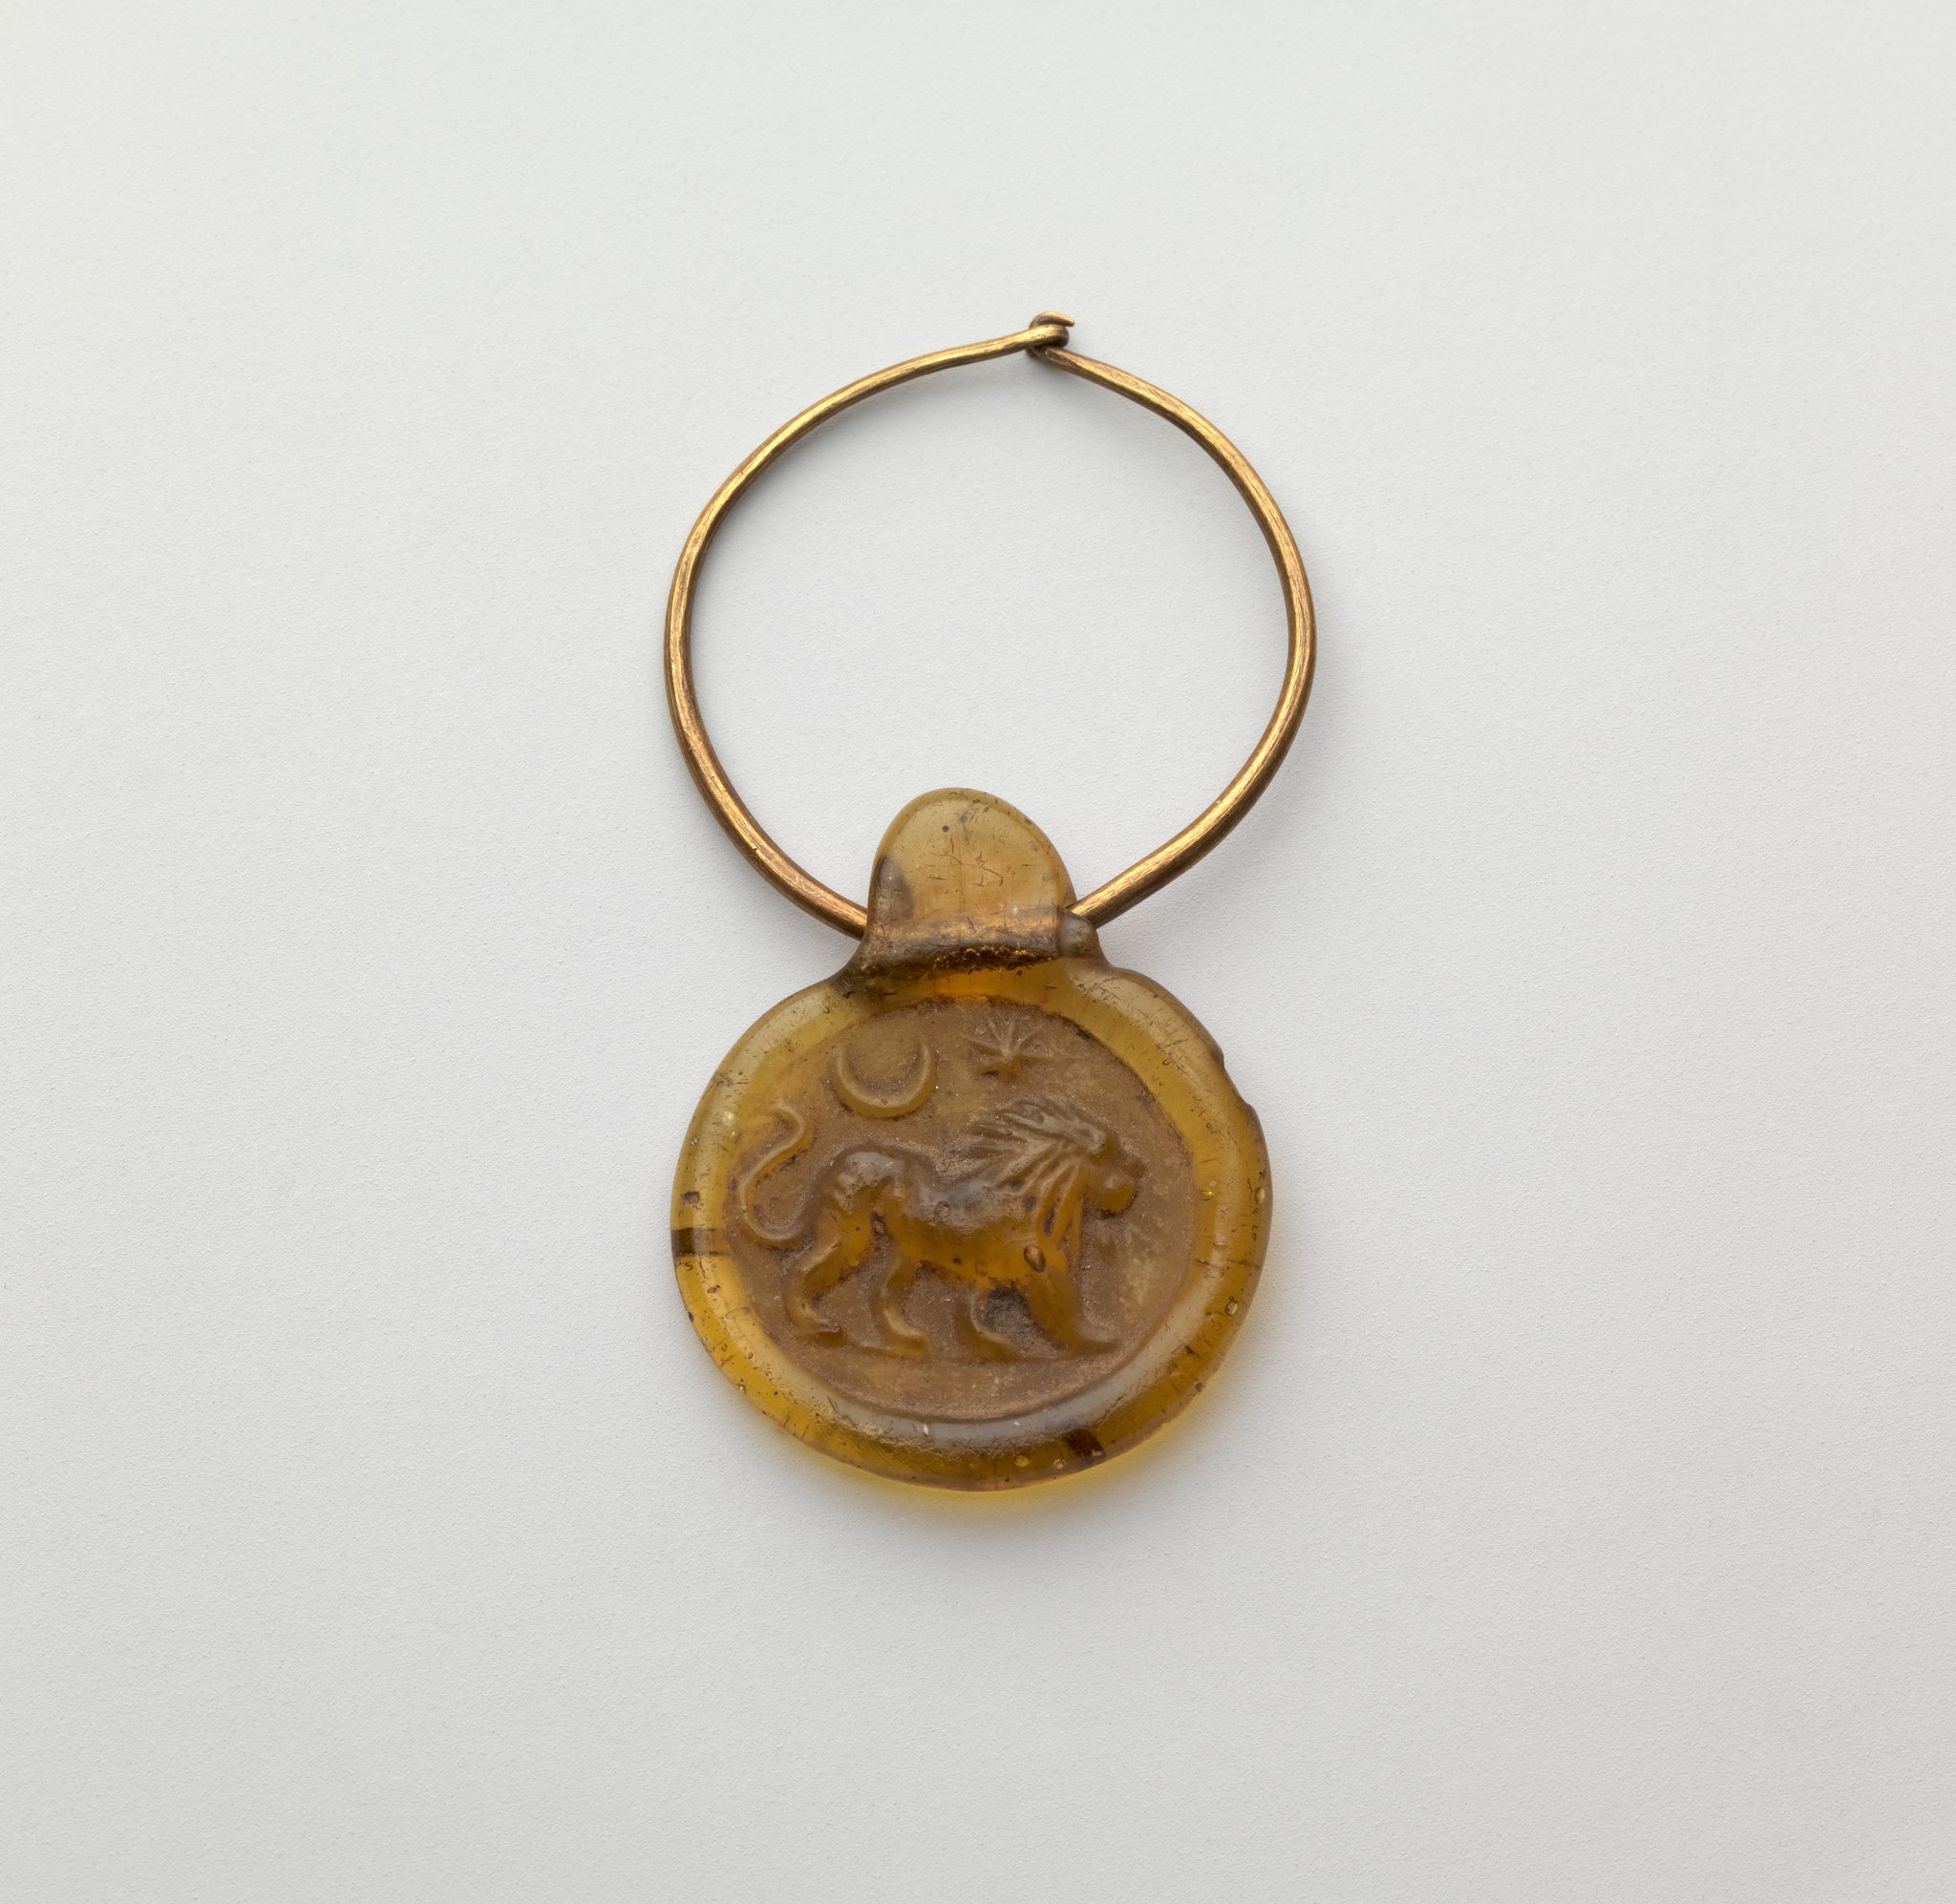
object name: pendant, stamped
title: Glass stamped disk pendant with gold hoop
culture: roman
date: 367-500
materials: glass, gold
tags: lions